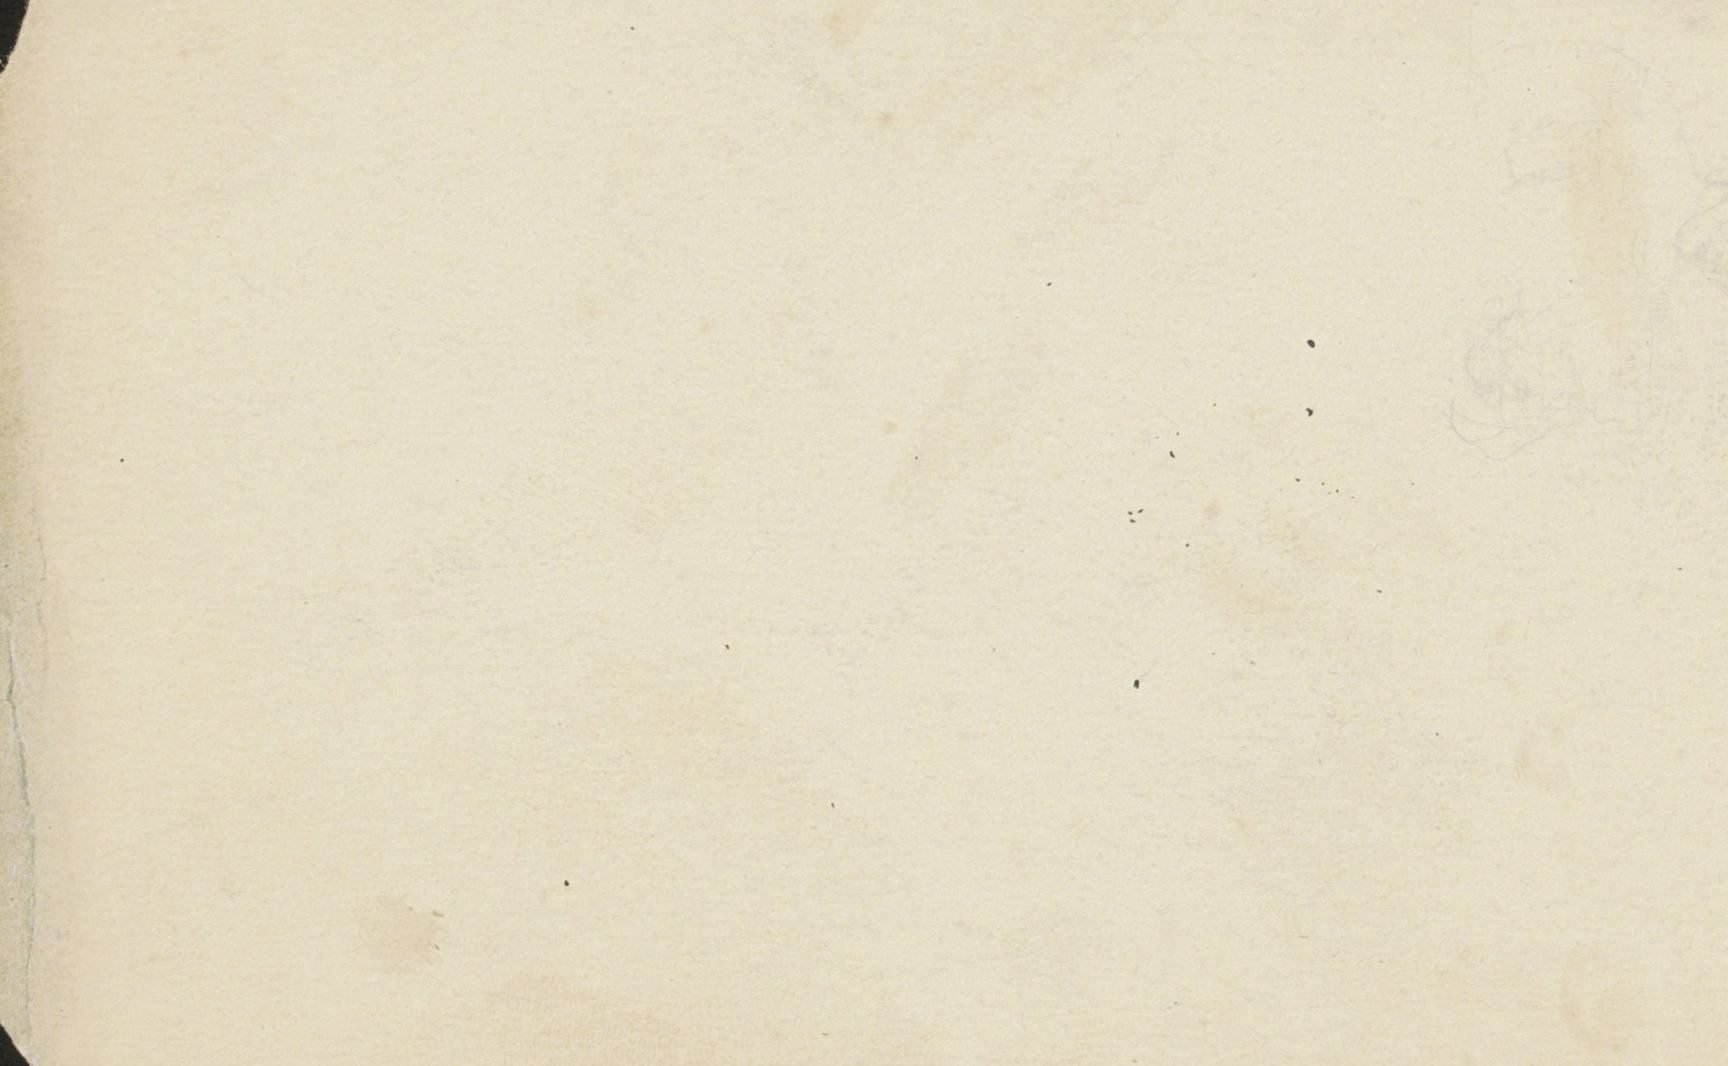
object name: sketchbook leaf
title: Vrouwenkop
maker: julie de graag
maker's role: draughtsman, print maker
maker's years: 1877-1924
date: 1894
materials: paper, pencil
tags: head (human), adult woman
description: Verso-zijde van een losse tekening tussen het schutblad en pagina 1 van een schetsboek met 35 bladen.